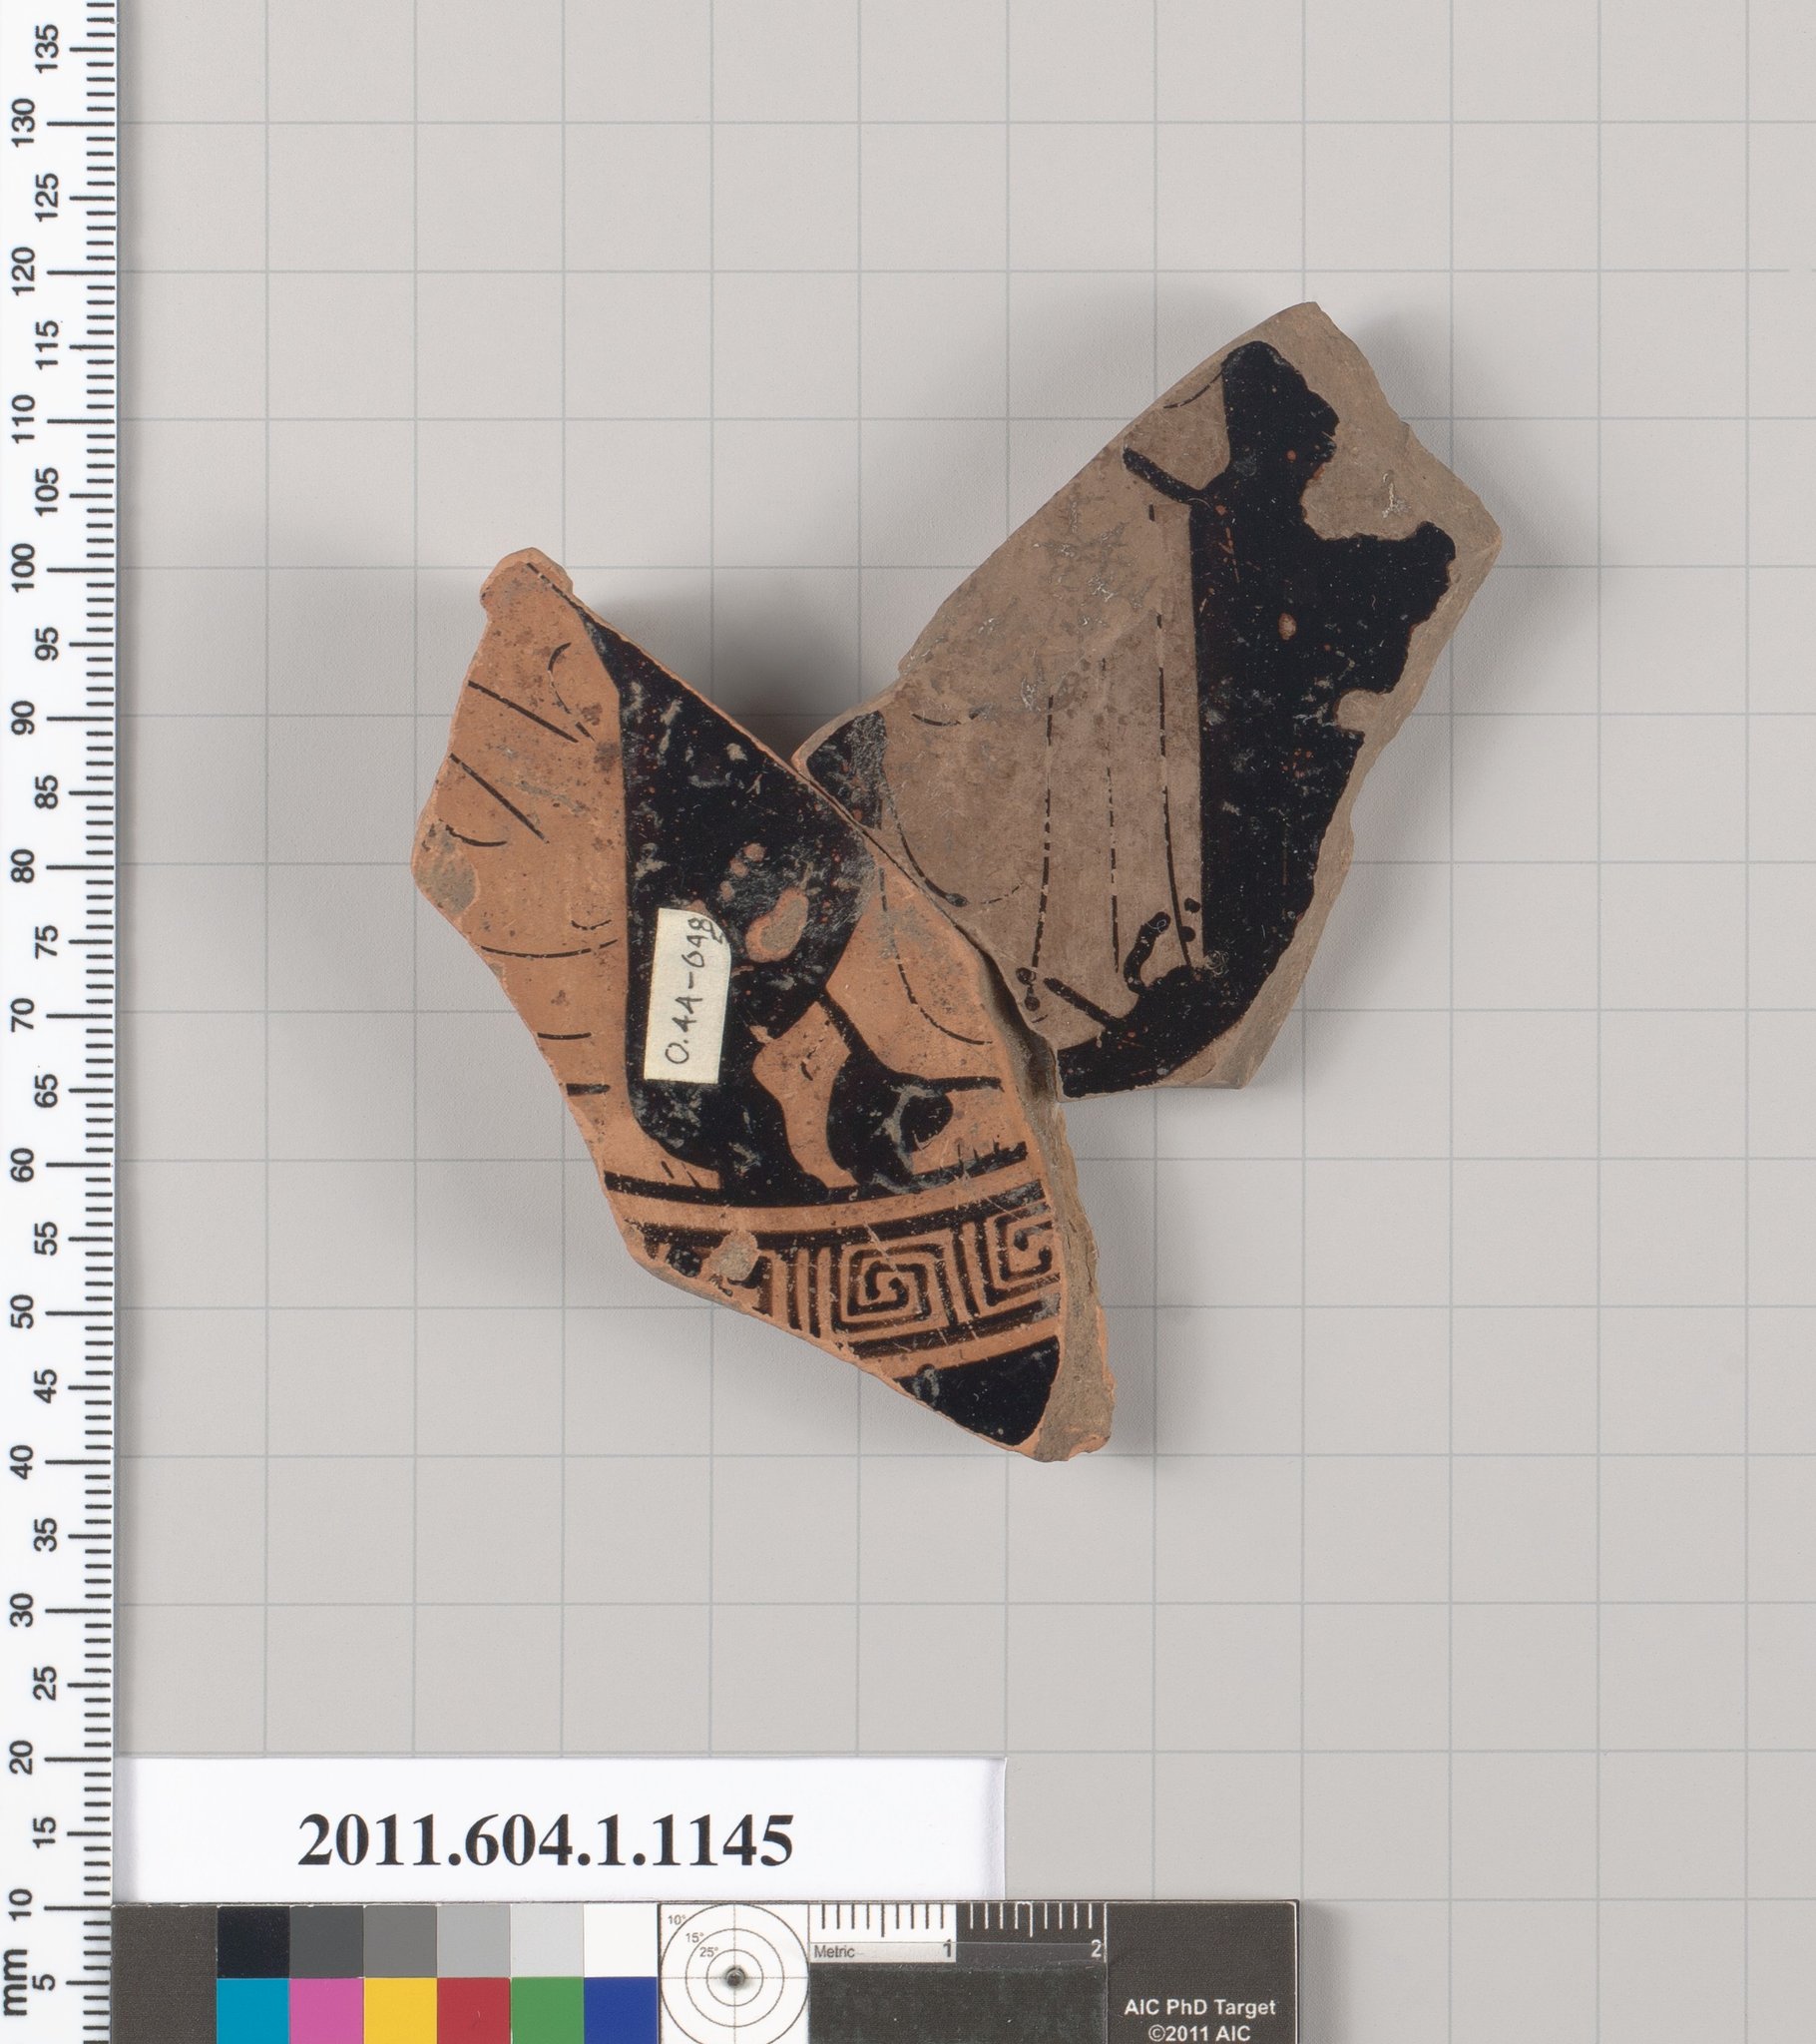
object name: kylix fragment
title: Terracotta fragment of a kylix (drinking cup)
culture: greek, attic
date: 467-435 BCE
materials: terracotta